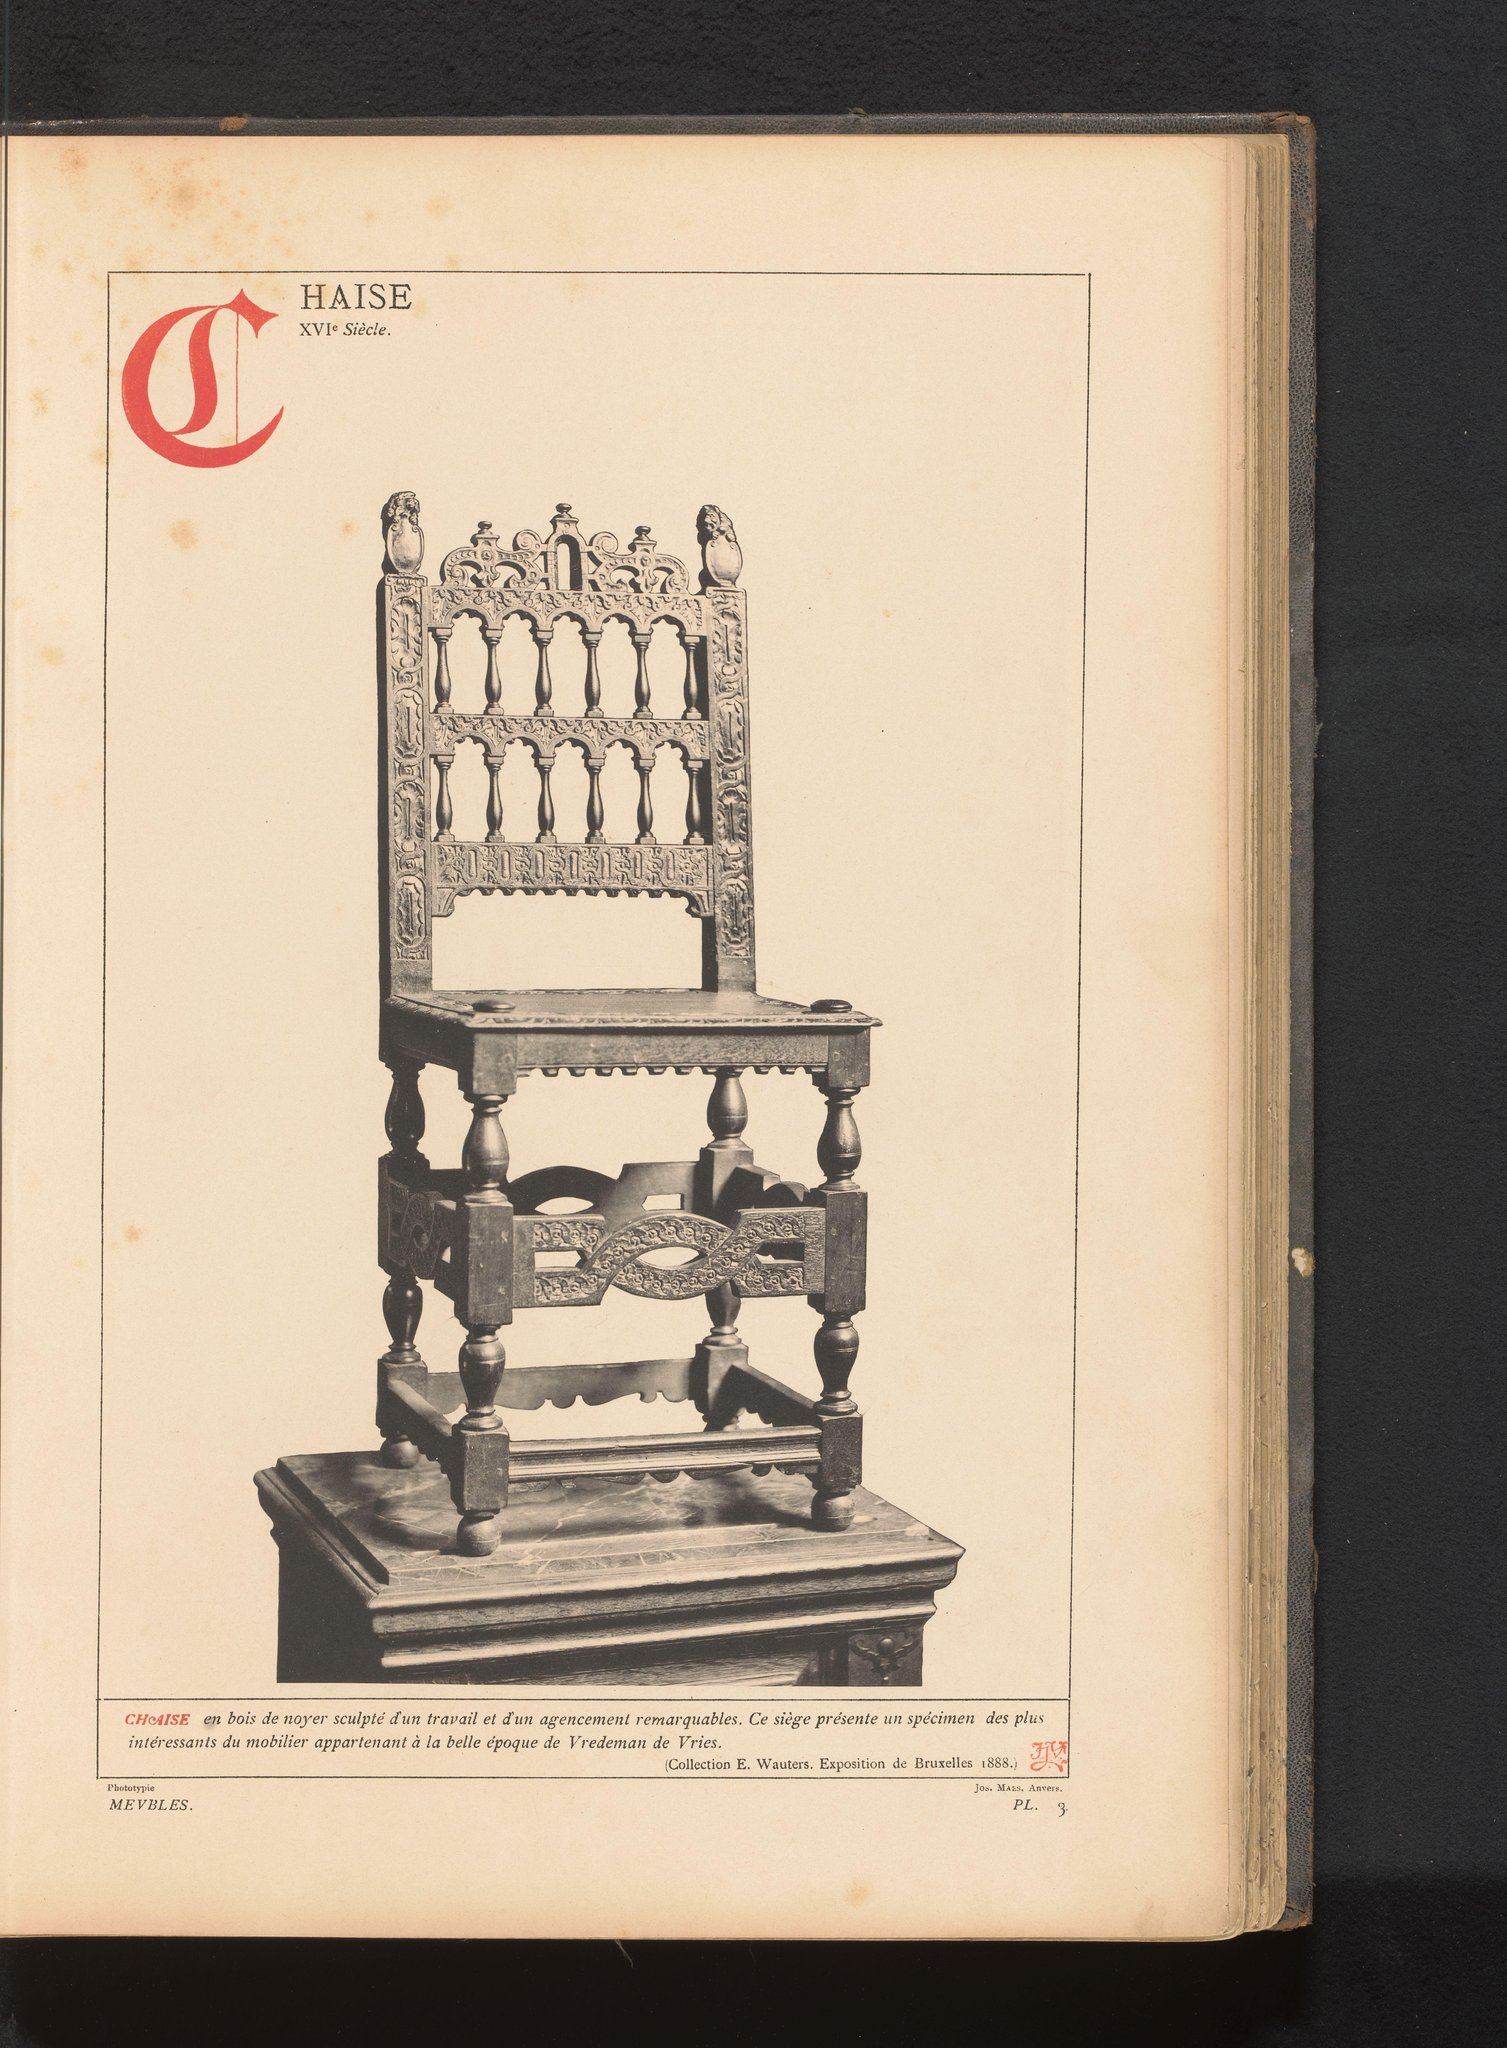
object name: photomechanical print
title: Chaise, XVIe Siècle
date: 1881-1889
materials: paper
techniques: photograph, photolithography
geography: antwerp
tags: chair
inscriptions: inscription: ‘MEUBLES. PL. 3.’, monogram: ‘JJvY’, inscription: ‘CHAISE en bois (...)’